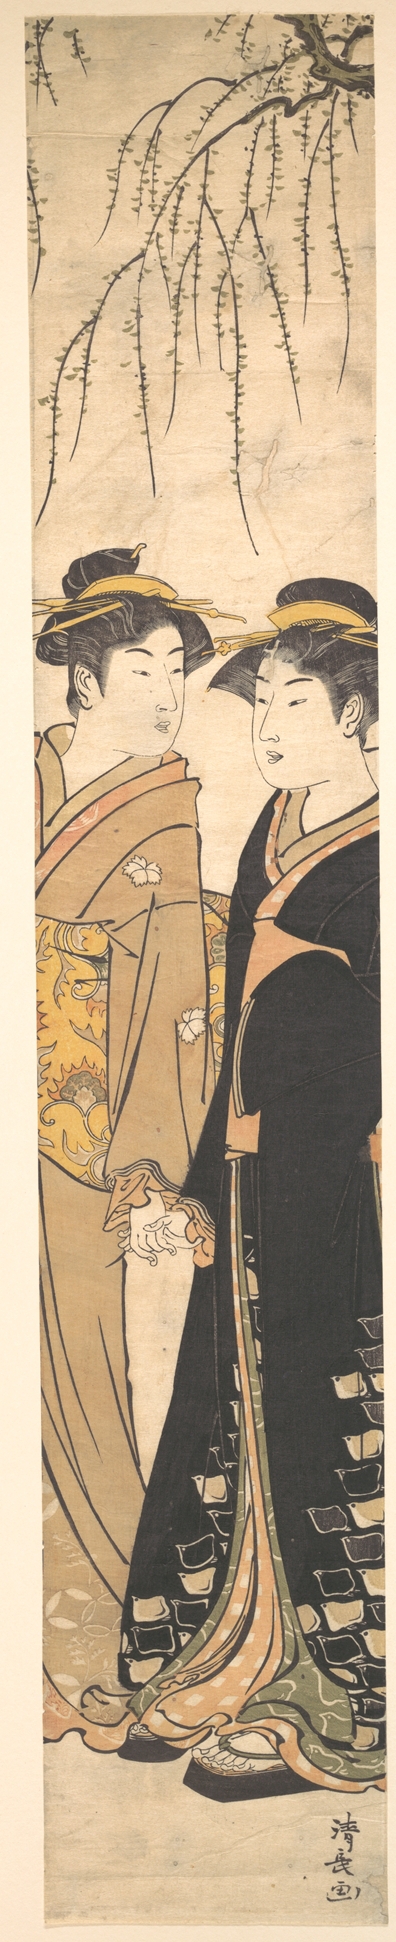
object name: woodblock print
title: Two Tall Young Women Walking Hand in Hand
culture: japanese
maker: torii kiyonaga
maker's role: artist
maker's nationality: japanese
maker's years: 1752-1815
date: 1785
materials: ink, paper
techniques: woodblock print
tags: women,walking